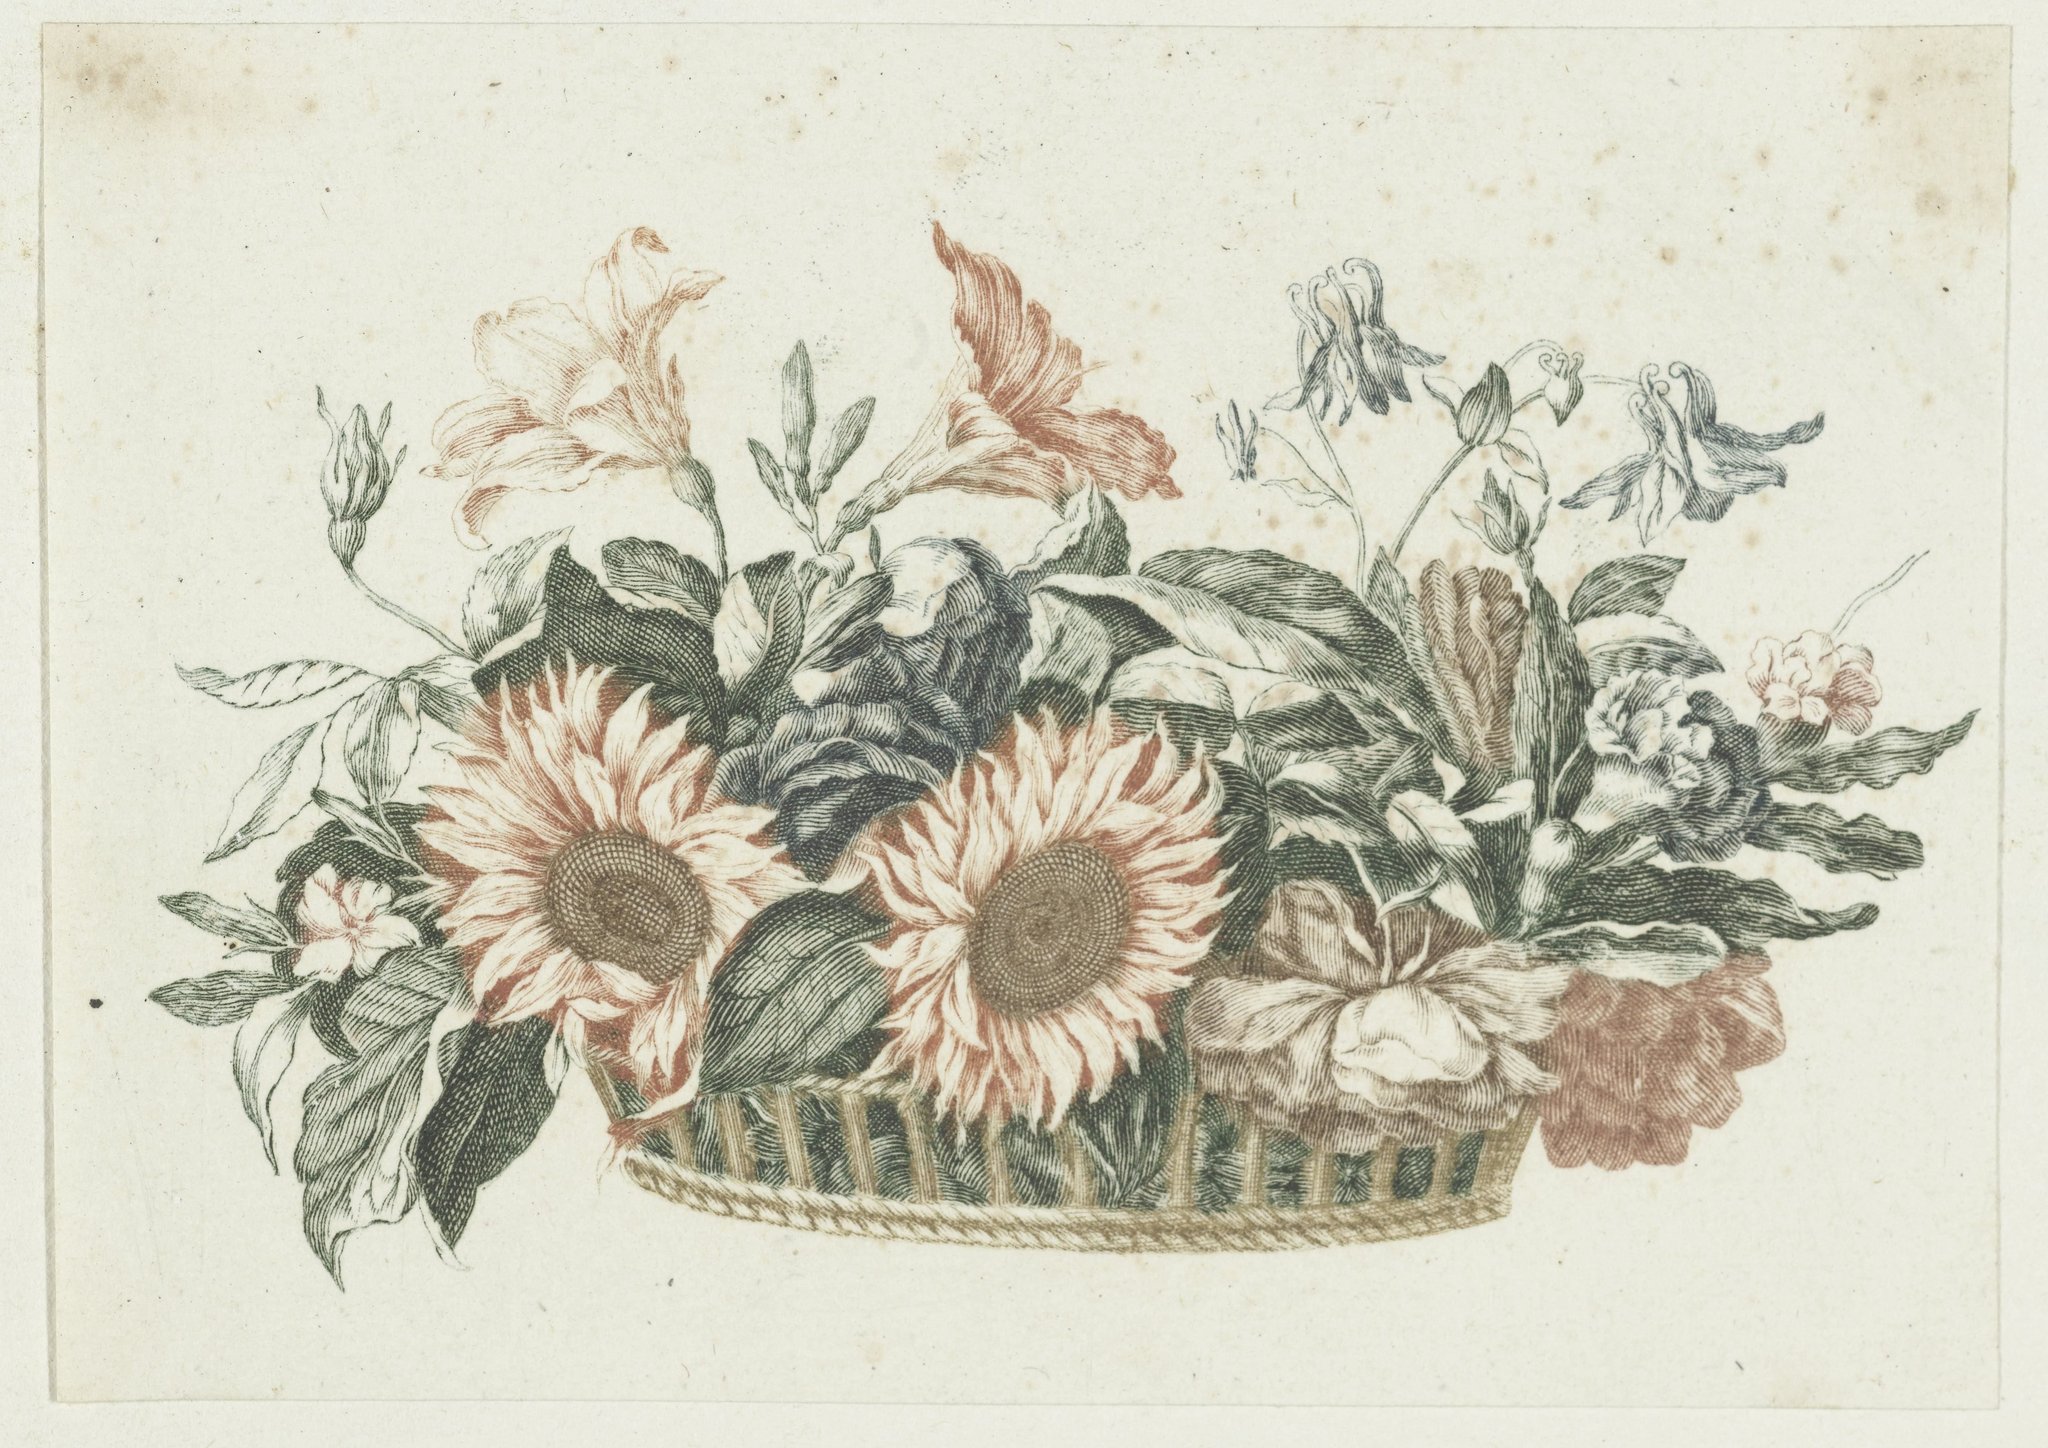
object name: print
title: Mand met bloemen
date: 1688-1698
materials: paper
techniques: printing, engraving, lithography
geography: netherlands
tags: flowers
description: Mand met bloemen, waaronder zonnebloemen. Deze prent maakt deel uit van een album.